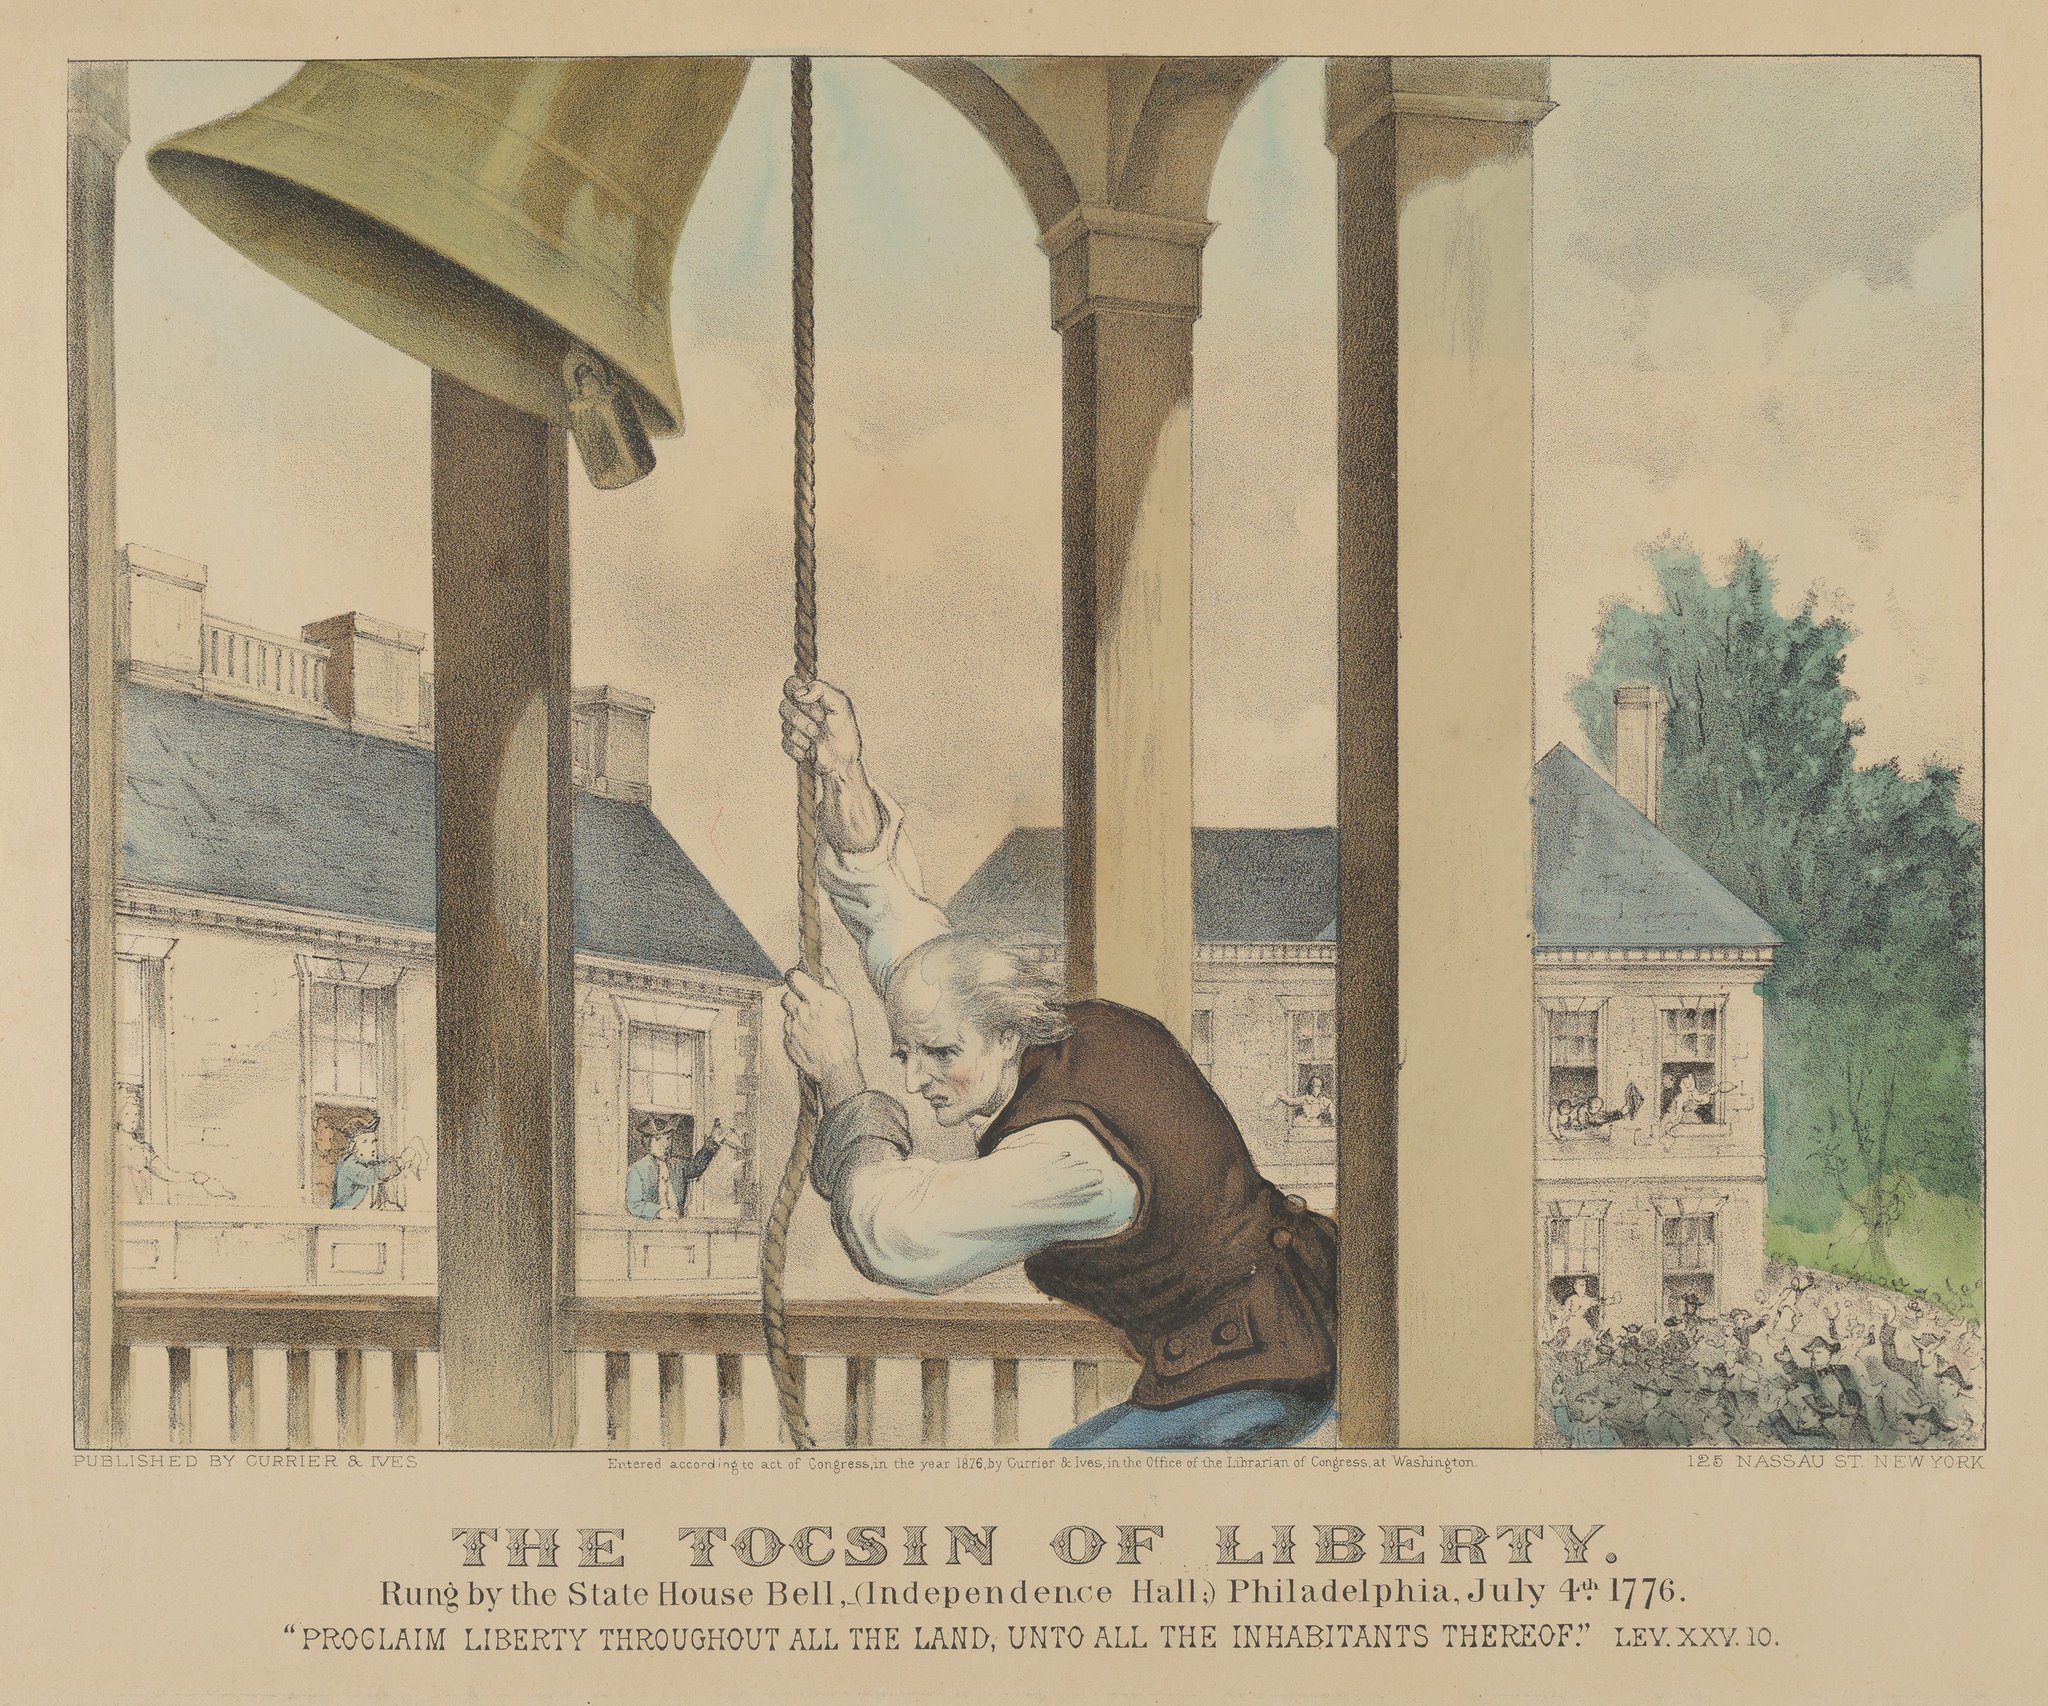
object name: print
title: The Tocsin of Liberty–Rung by the State House Bell, (Independence Hall) Philadelphia, July 4th, 1776, "Proclaim liberty throughout all the land, unto all the inhabitants thereof" LEV.XXV.10.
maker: currier & ives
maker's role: publisher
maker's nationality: american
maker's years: 1857-1907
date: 1876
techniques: hand coloring, lithograph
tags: musical instruments,men,crowd